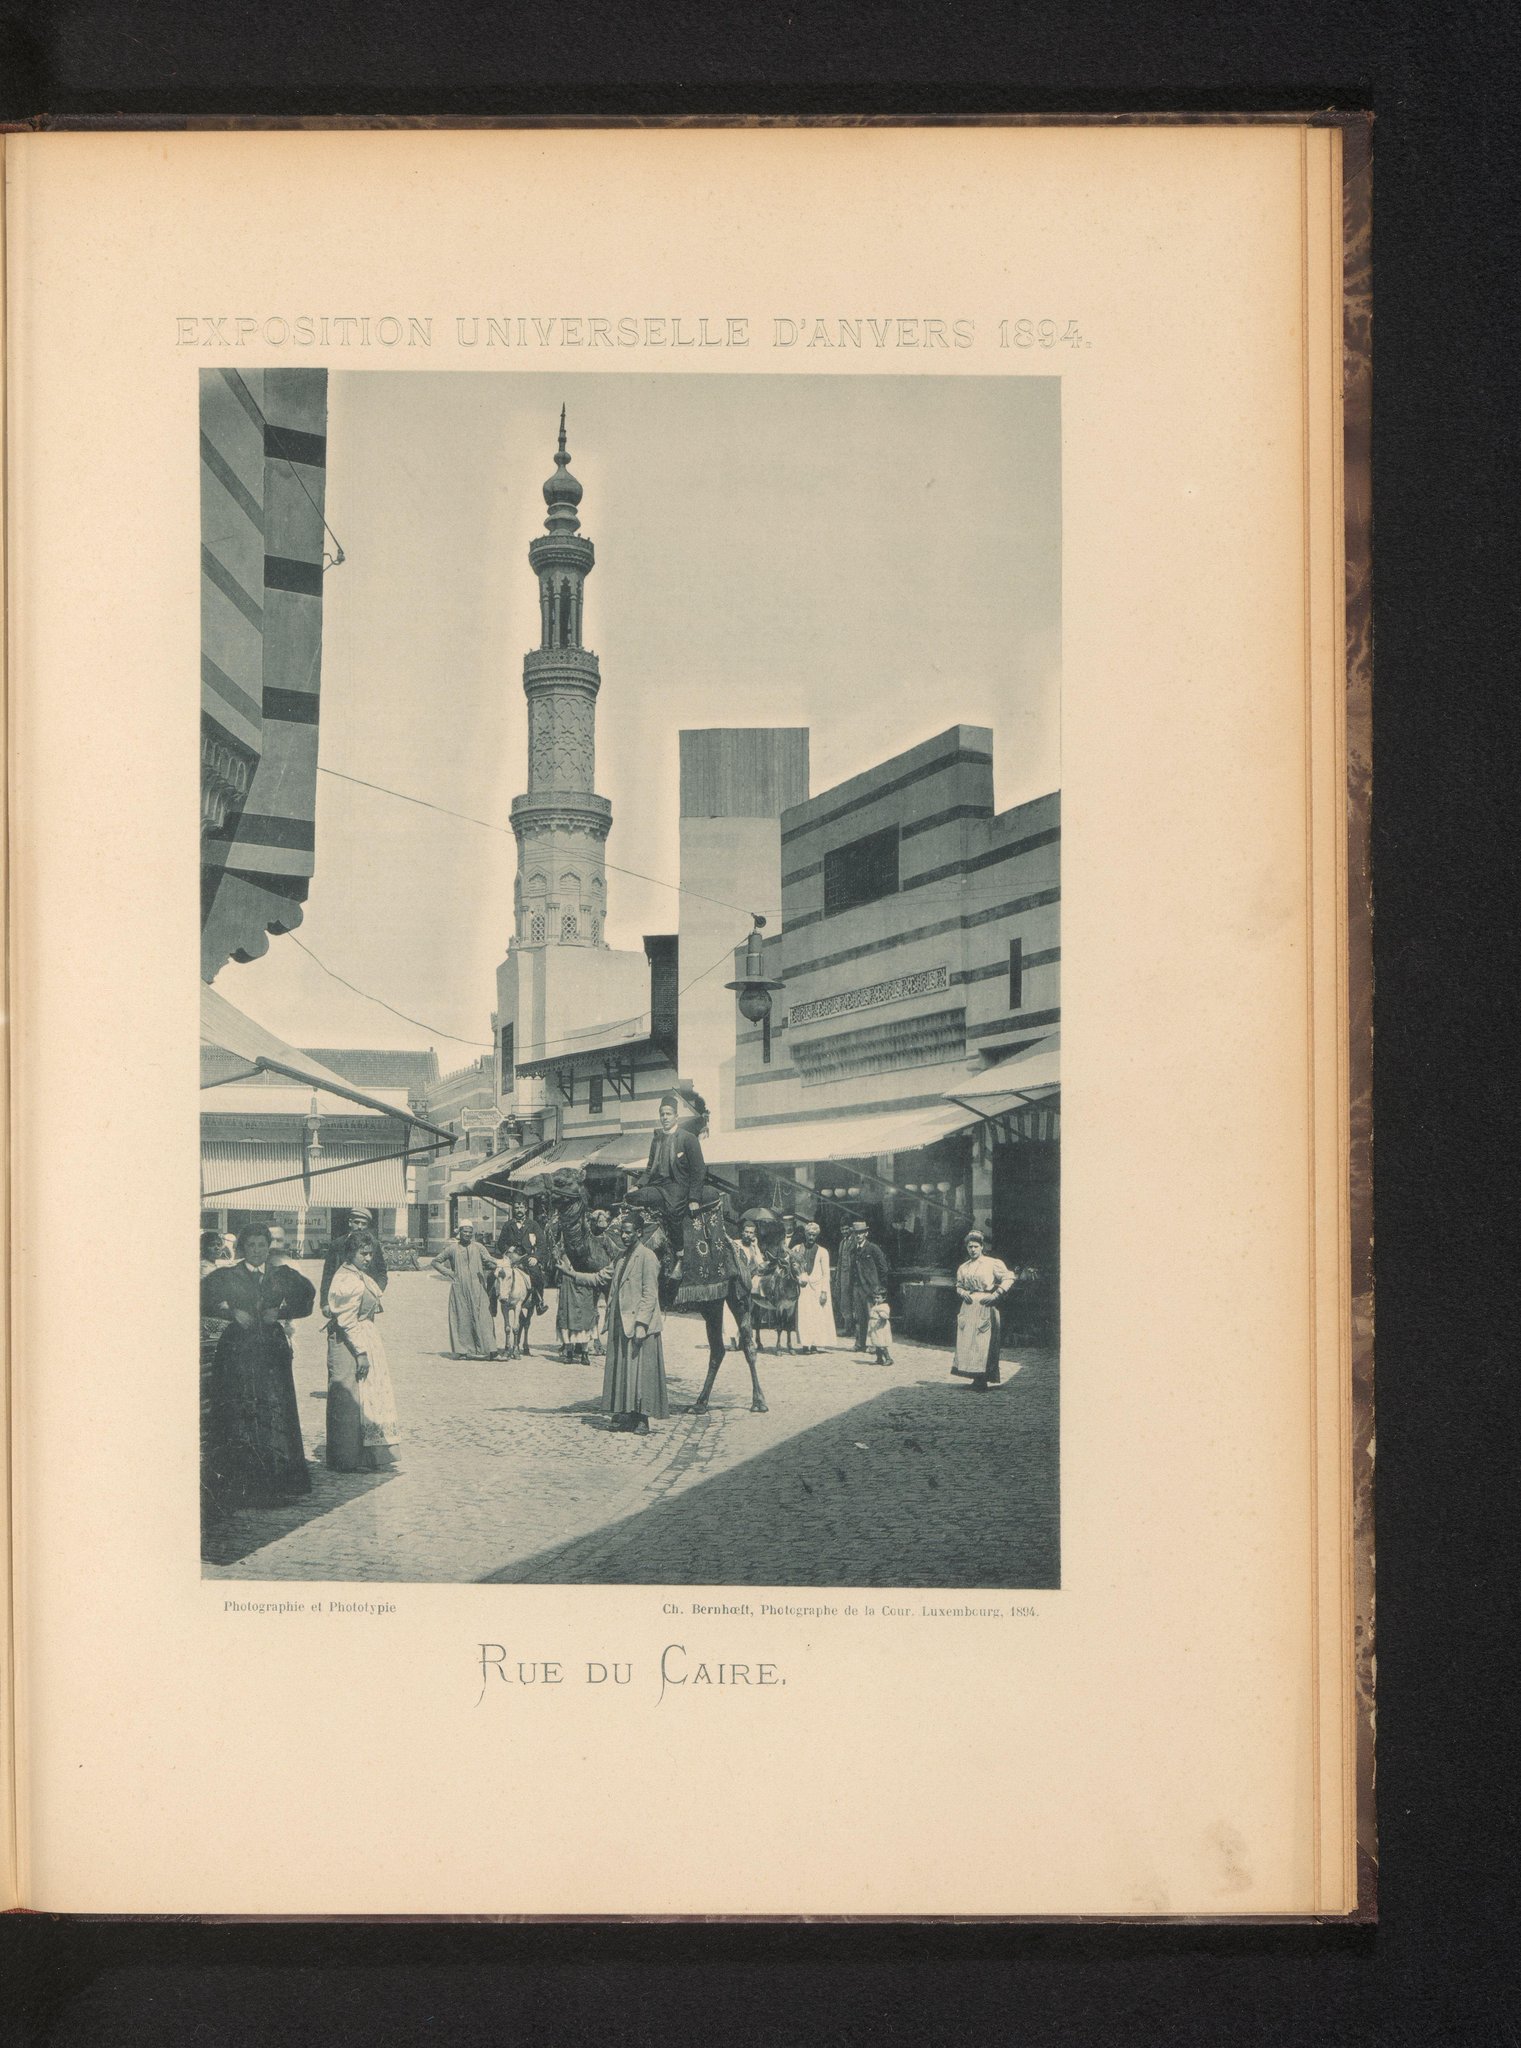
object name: page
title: Exposition Universelle d'Anvers 1894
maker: charles bernhoeft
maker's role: publisher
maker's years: 1859-1933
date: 1894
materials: paper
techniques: photograph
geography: antwerp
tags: hoofed animals: camel, world fair, world exhibition, adult man, street, antwerp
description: Prent op derde ongenummerde pagina na pagina 134.